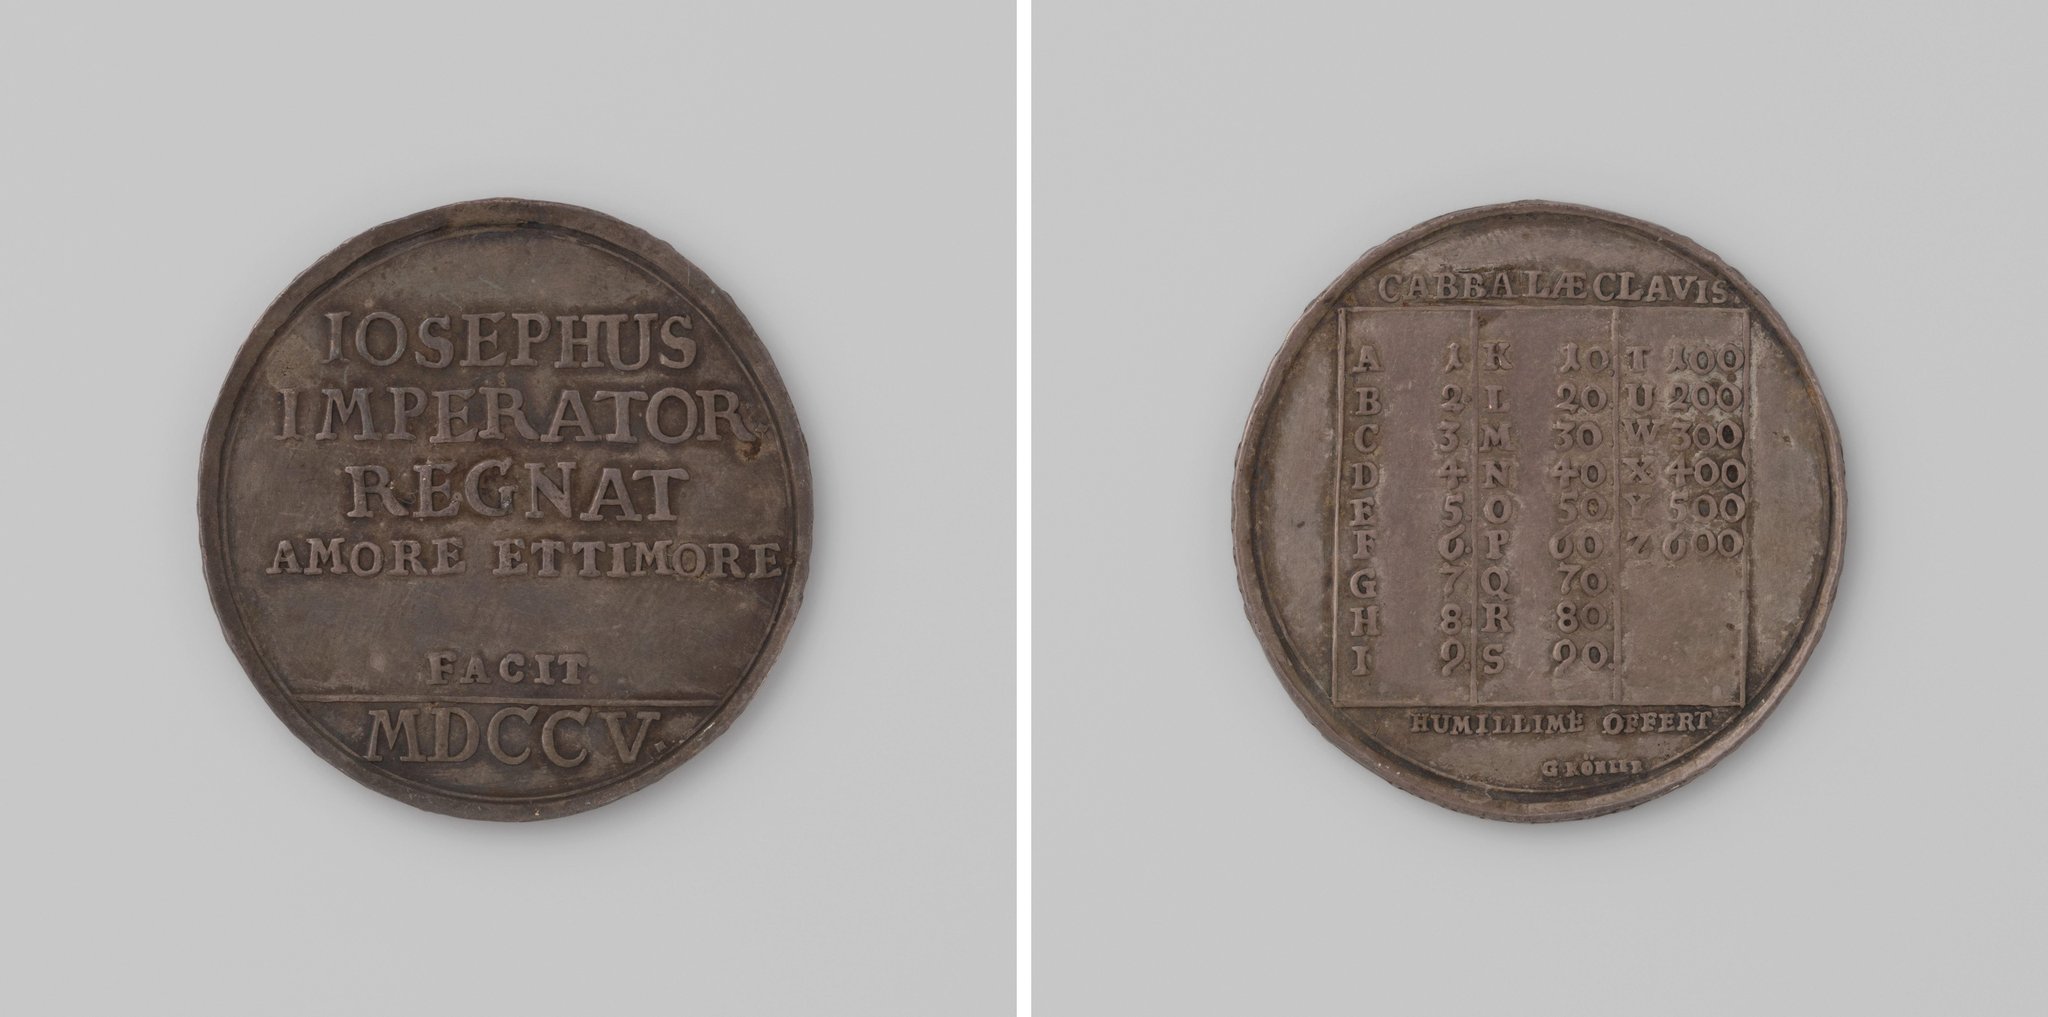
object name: history medal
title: Kroning van Jozef I tot Duits keizer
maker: g.v. koehler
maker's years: 1705-1711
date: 1705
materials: silver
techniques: striking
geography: germany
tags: vienna, jozef i (duits keizer)